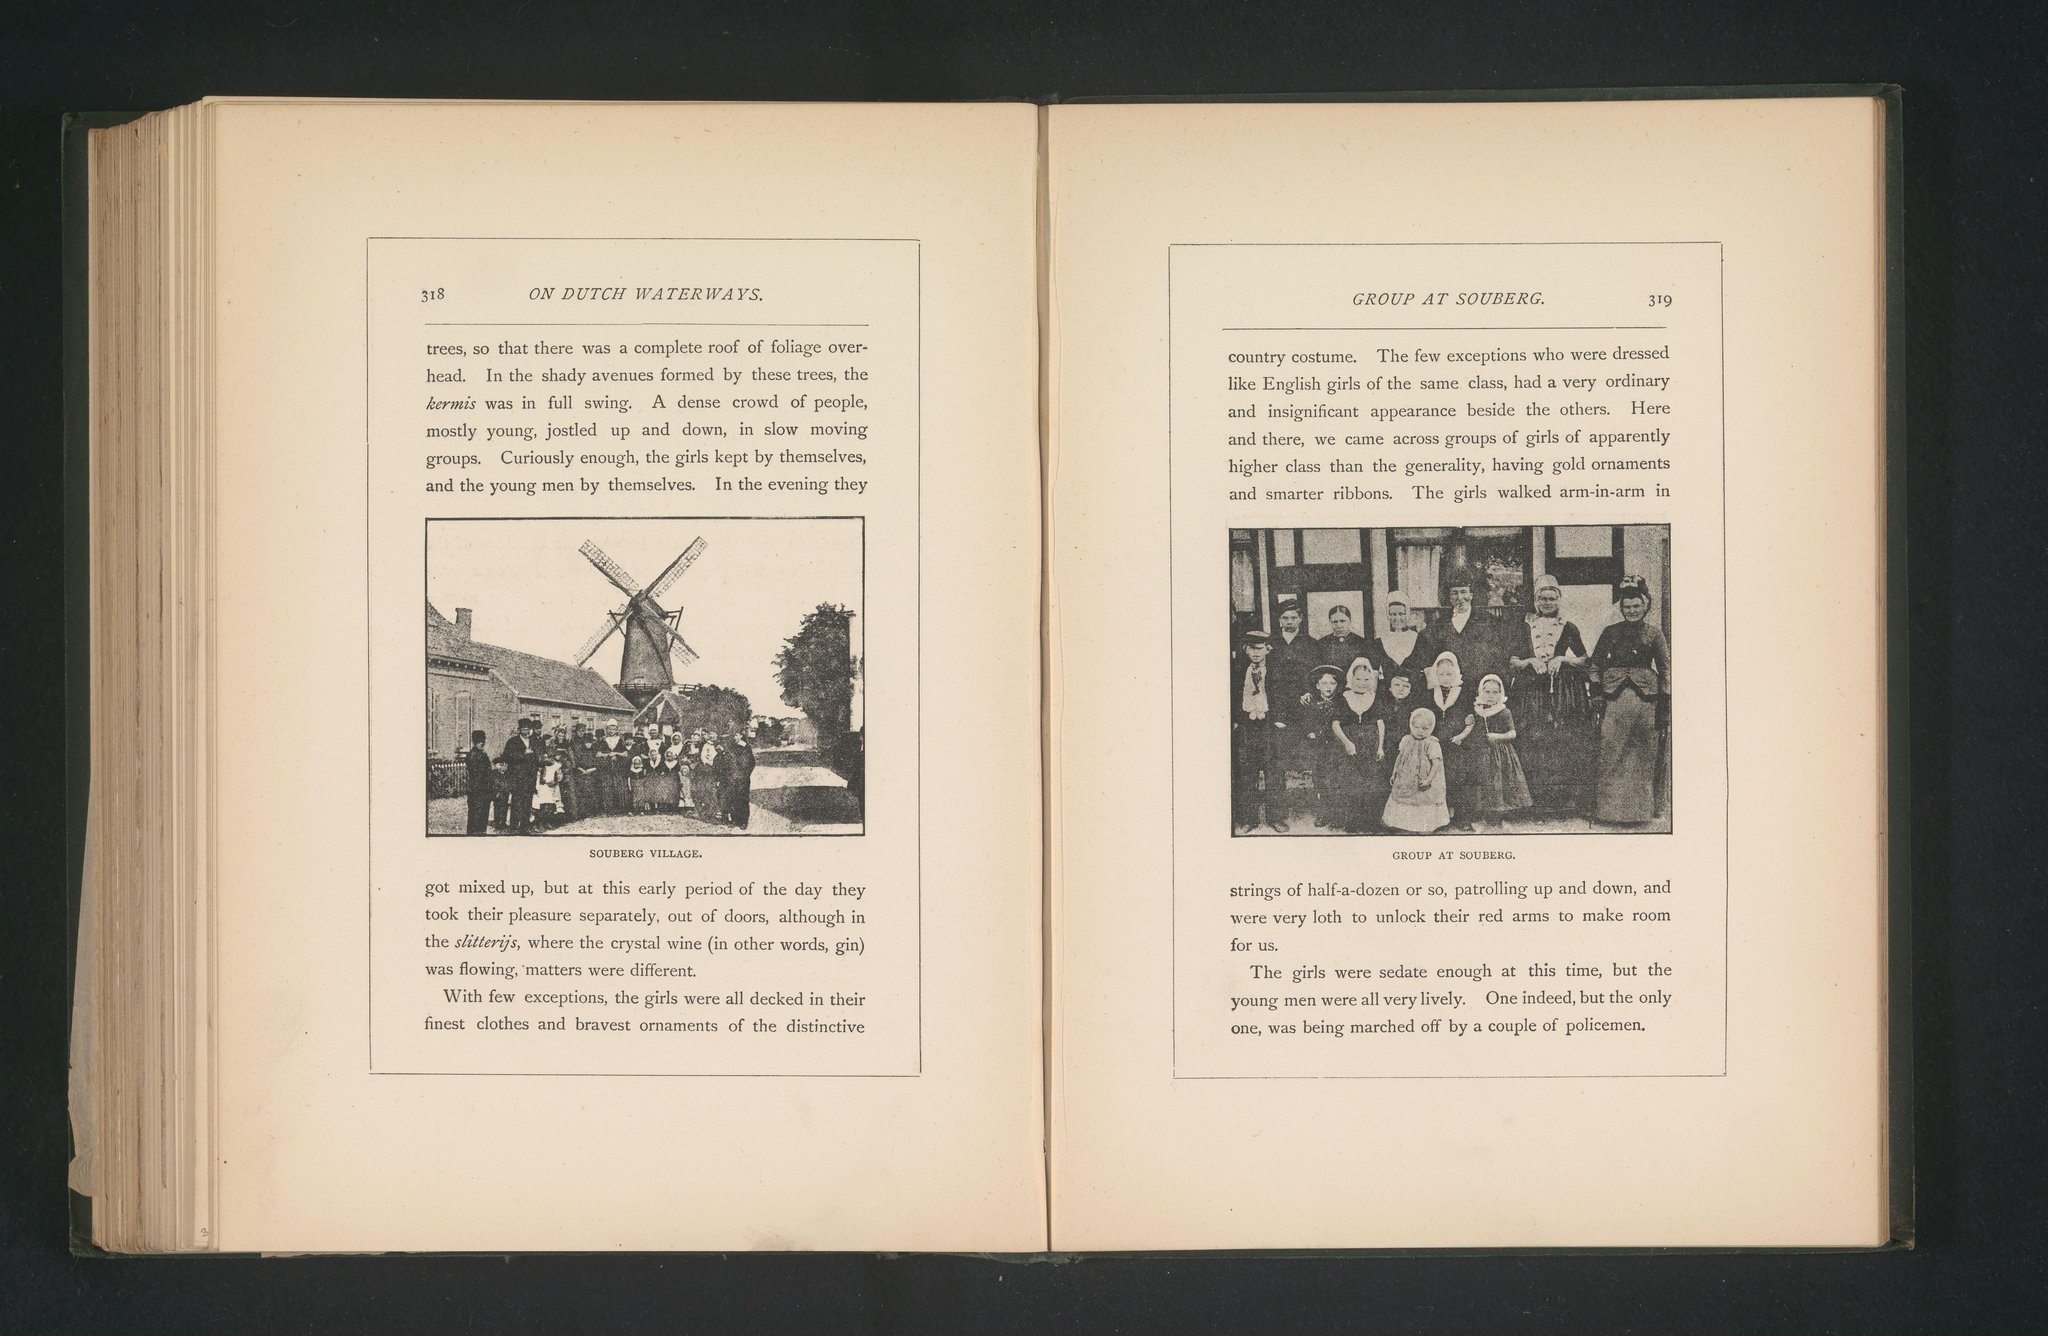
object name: page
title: Groepsportret van mannen, vrouwen en kinderen in Oost-Souburg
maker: george christopher davies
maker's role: fotograaf, geoloog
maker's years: 1849-1922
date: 1881-1886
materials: paper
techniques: autotype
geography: london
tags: adult woman, adult man, child, anonymous historical persons portrayed in a group, in a group-portrait